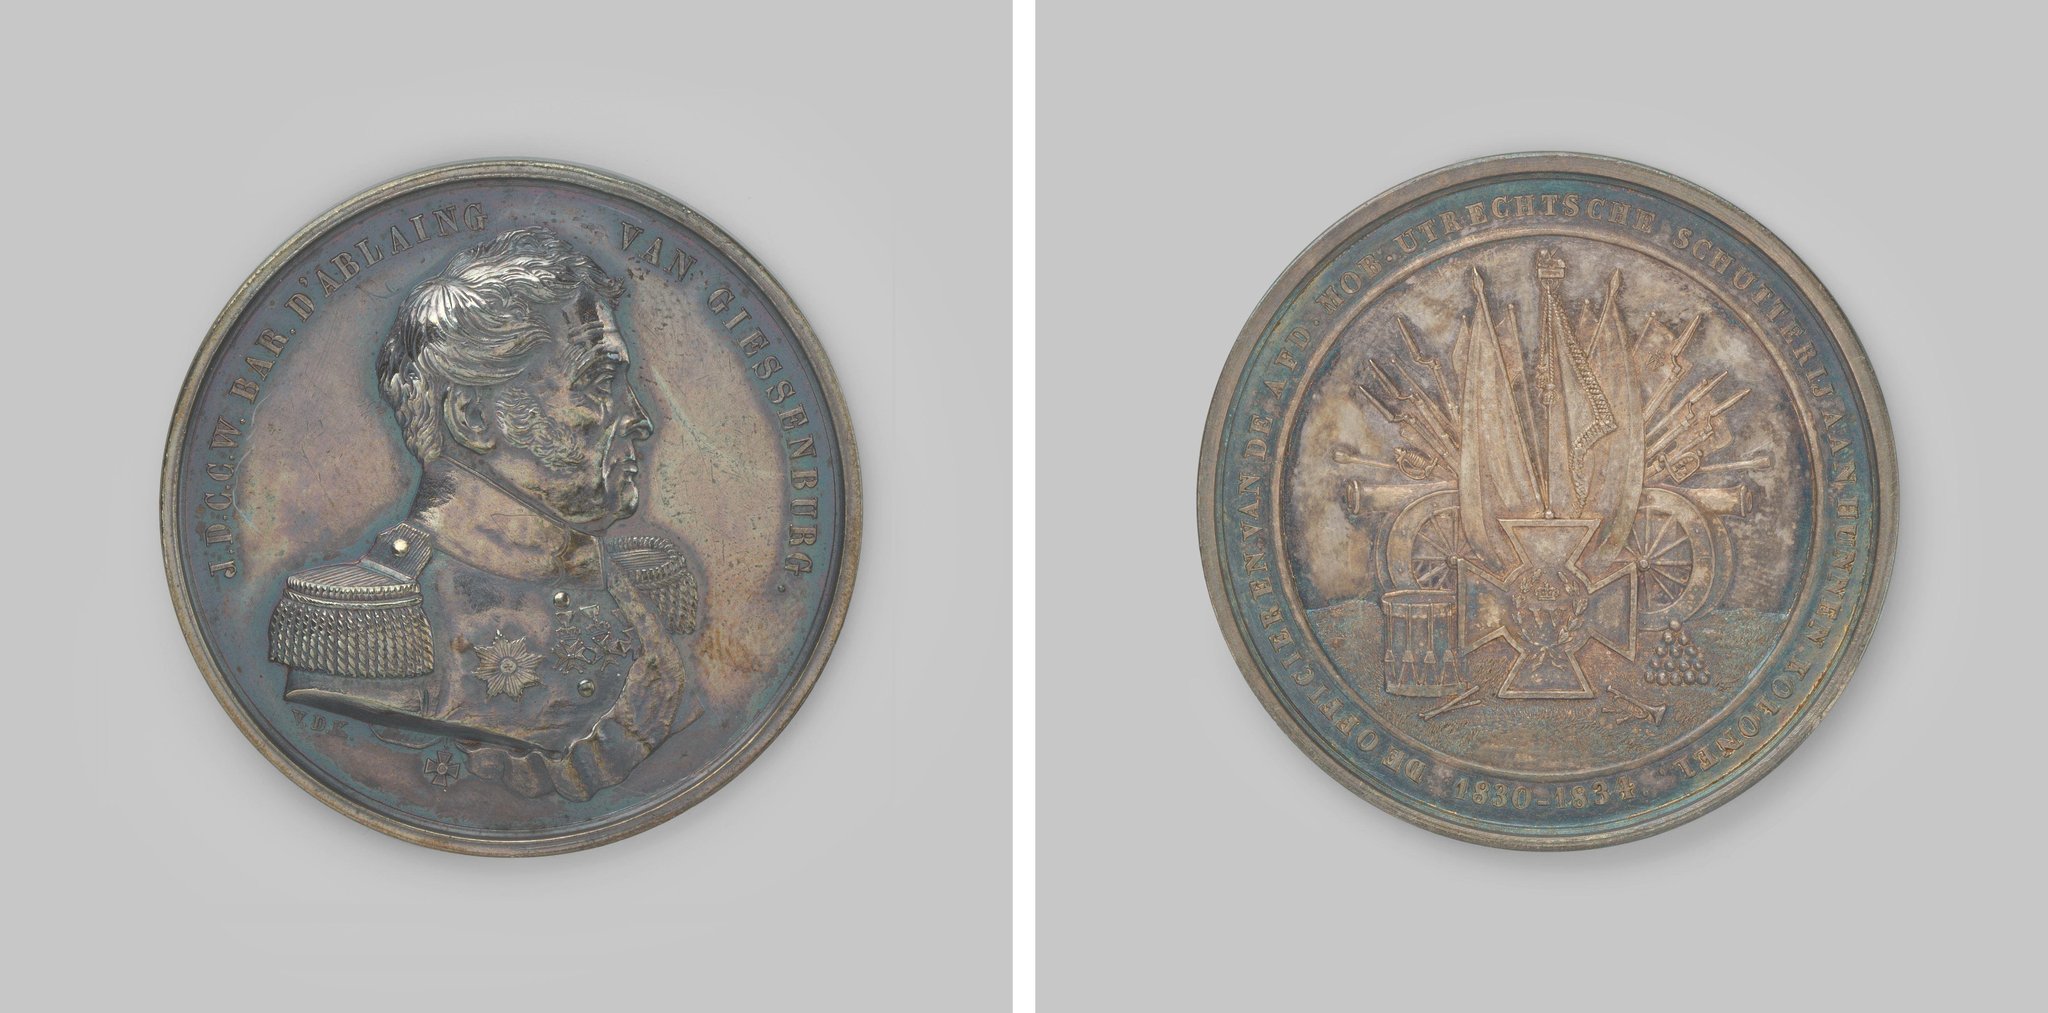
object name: history medal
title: Gedenkpenning, aangeboden door de officieren van de mobiele schutterij te Utrecht aan hun kolonel J.D.C.C. baron d'Ablaing van Giessenburg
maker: david van der kellen (1804-1879)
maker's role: die cutter, draughtsman, print maker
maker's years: 1804-1879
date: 1834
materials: bronze